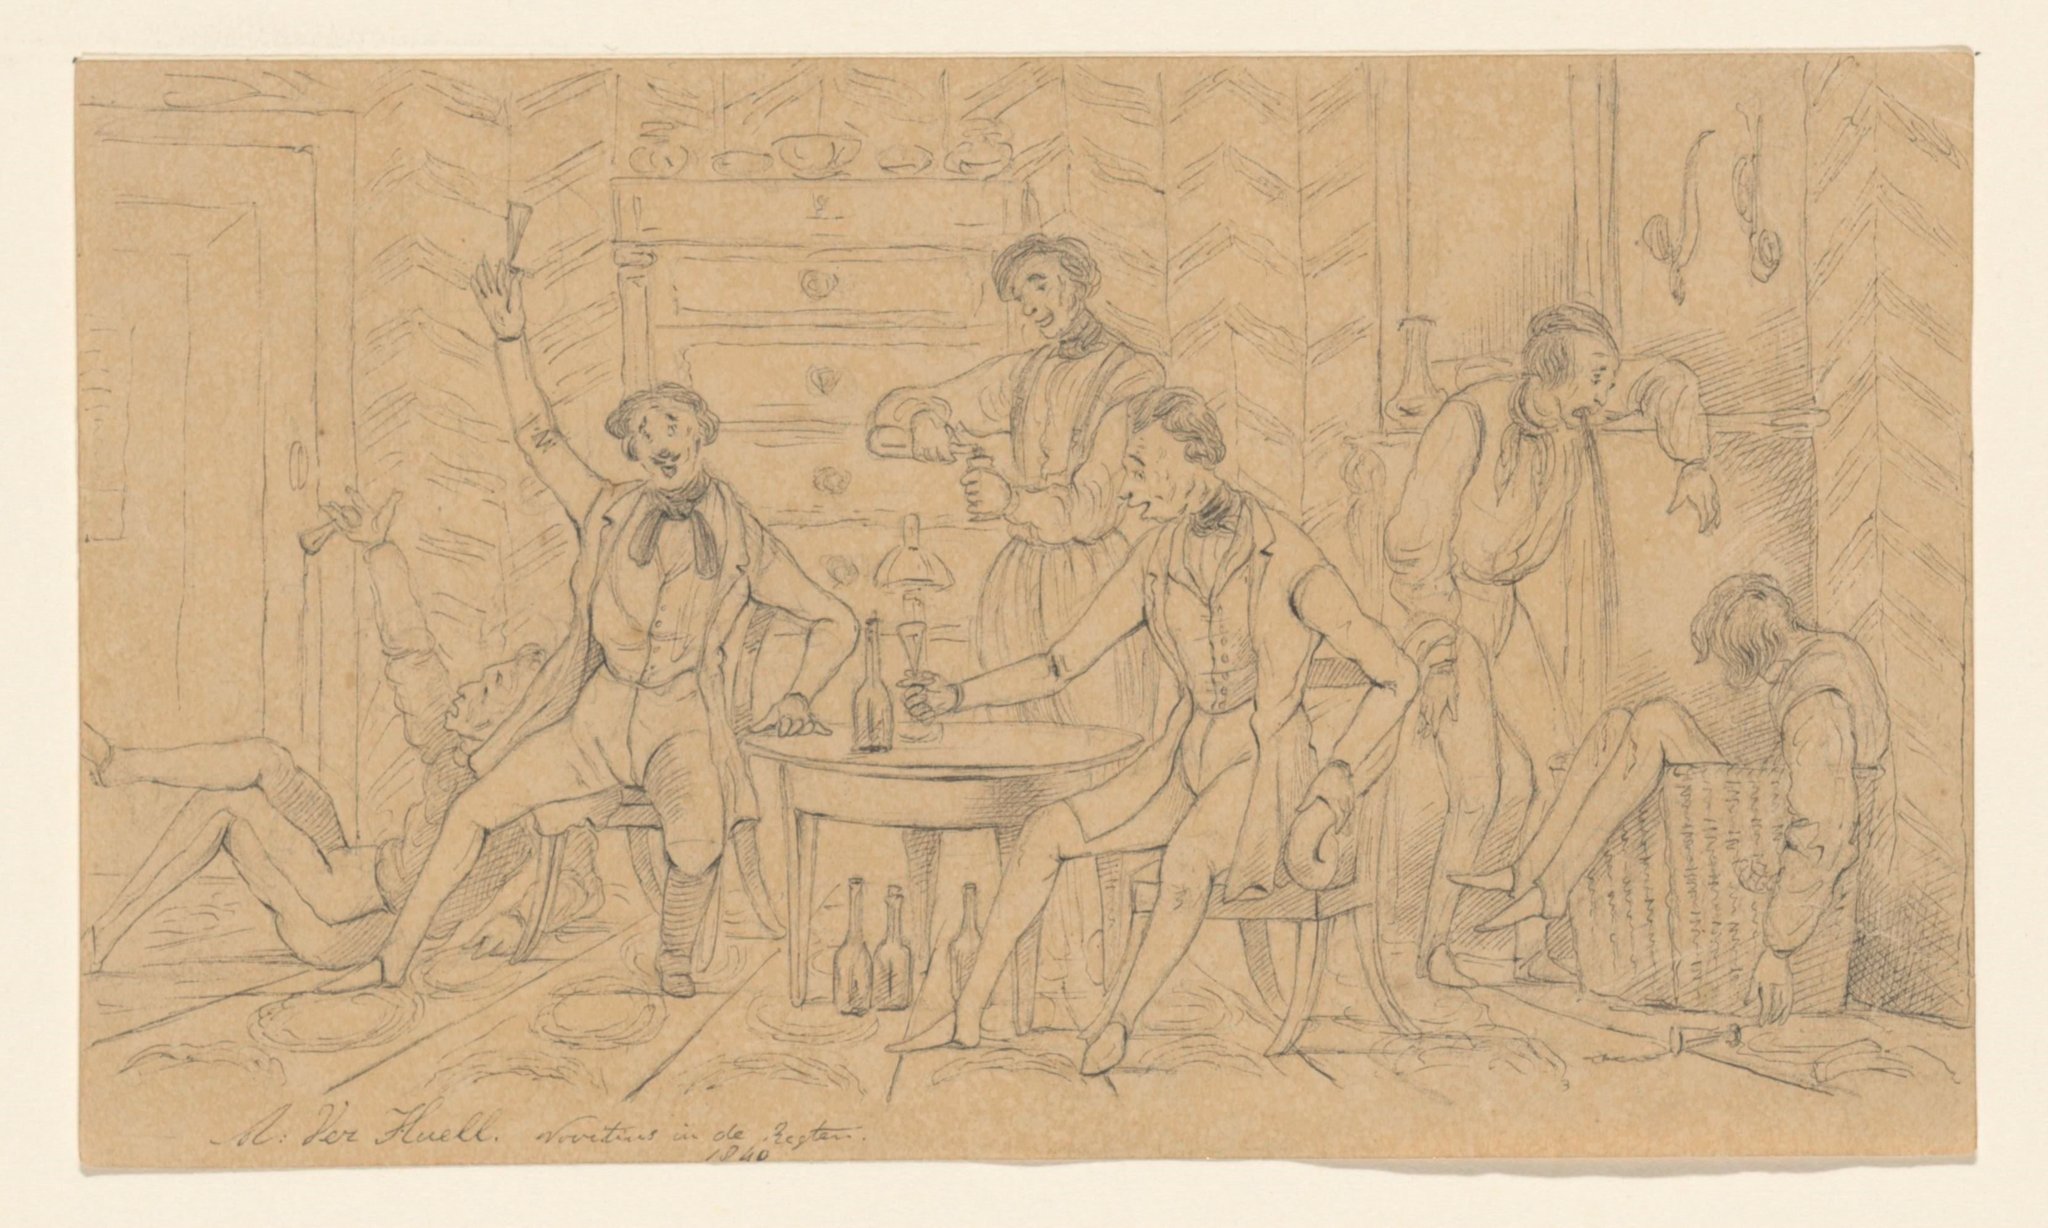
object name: drawing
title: Ver Huell als Novitius in de rechten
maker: alexander ver huell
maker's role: draughtsman, print maker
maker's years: 1822-1897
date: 1840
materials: ink, paper, pencil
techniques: pen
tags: drinking